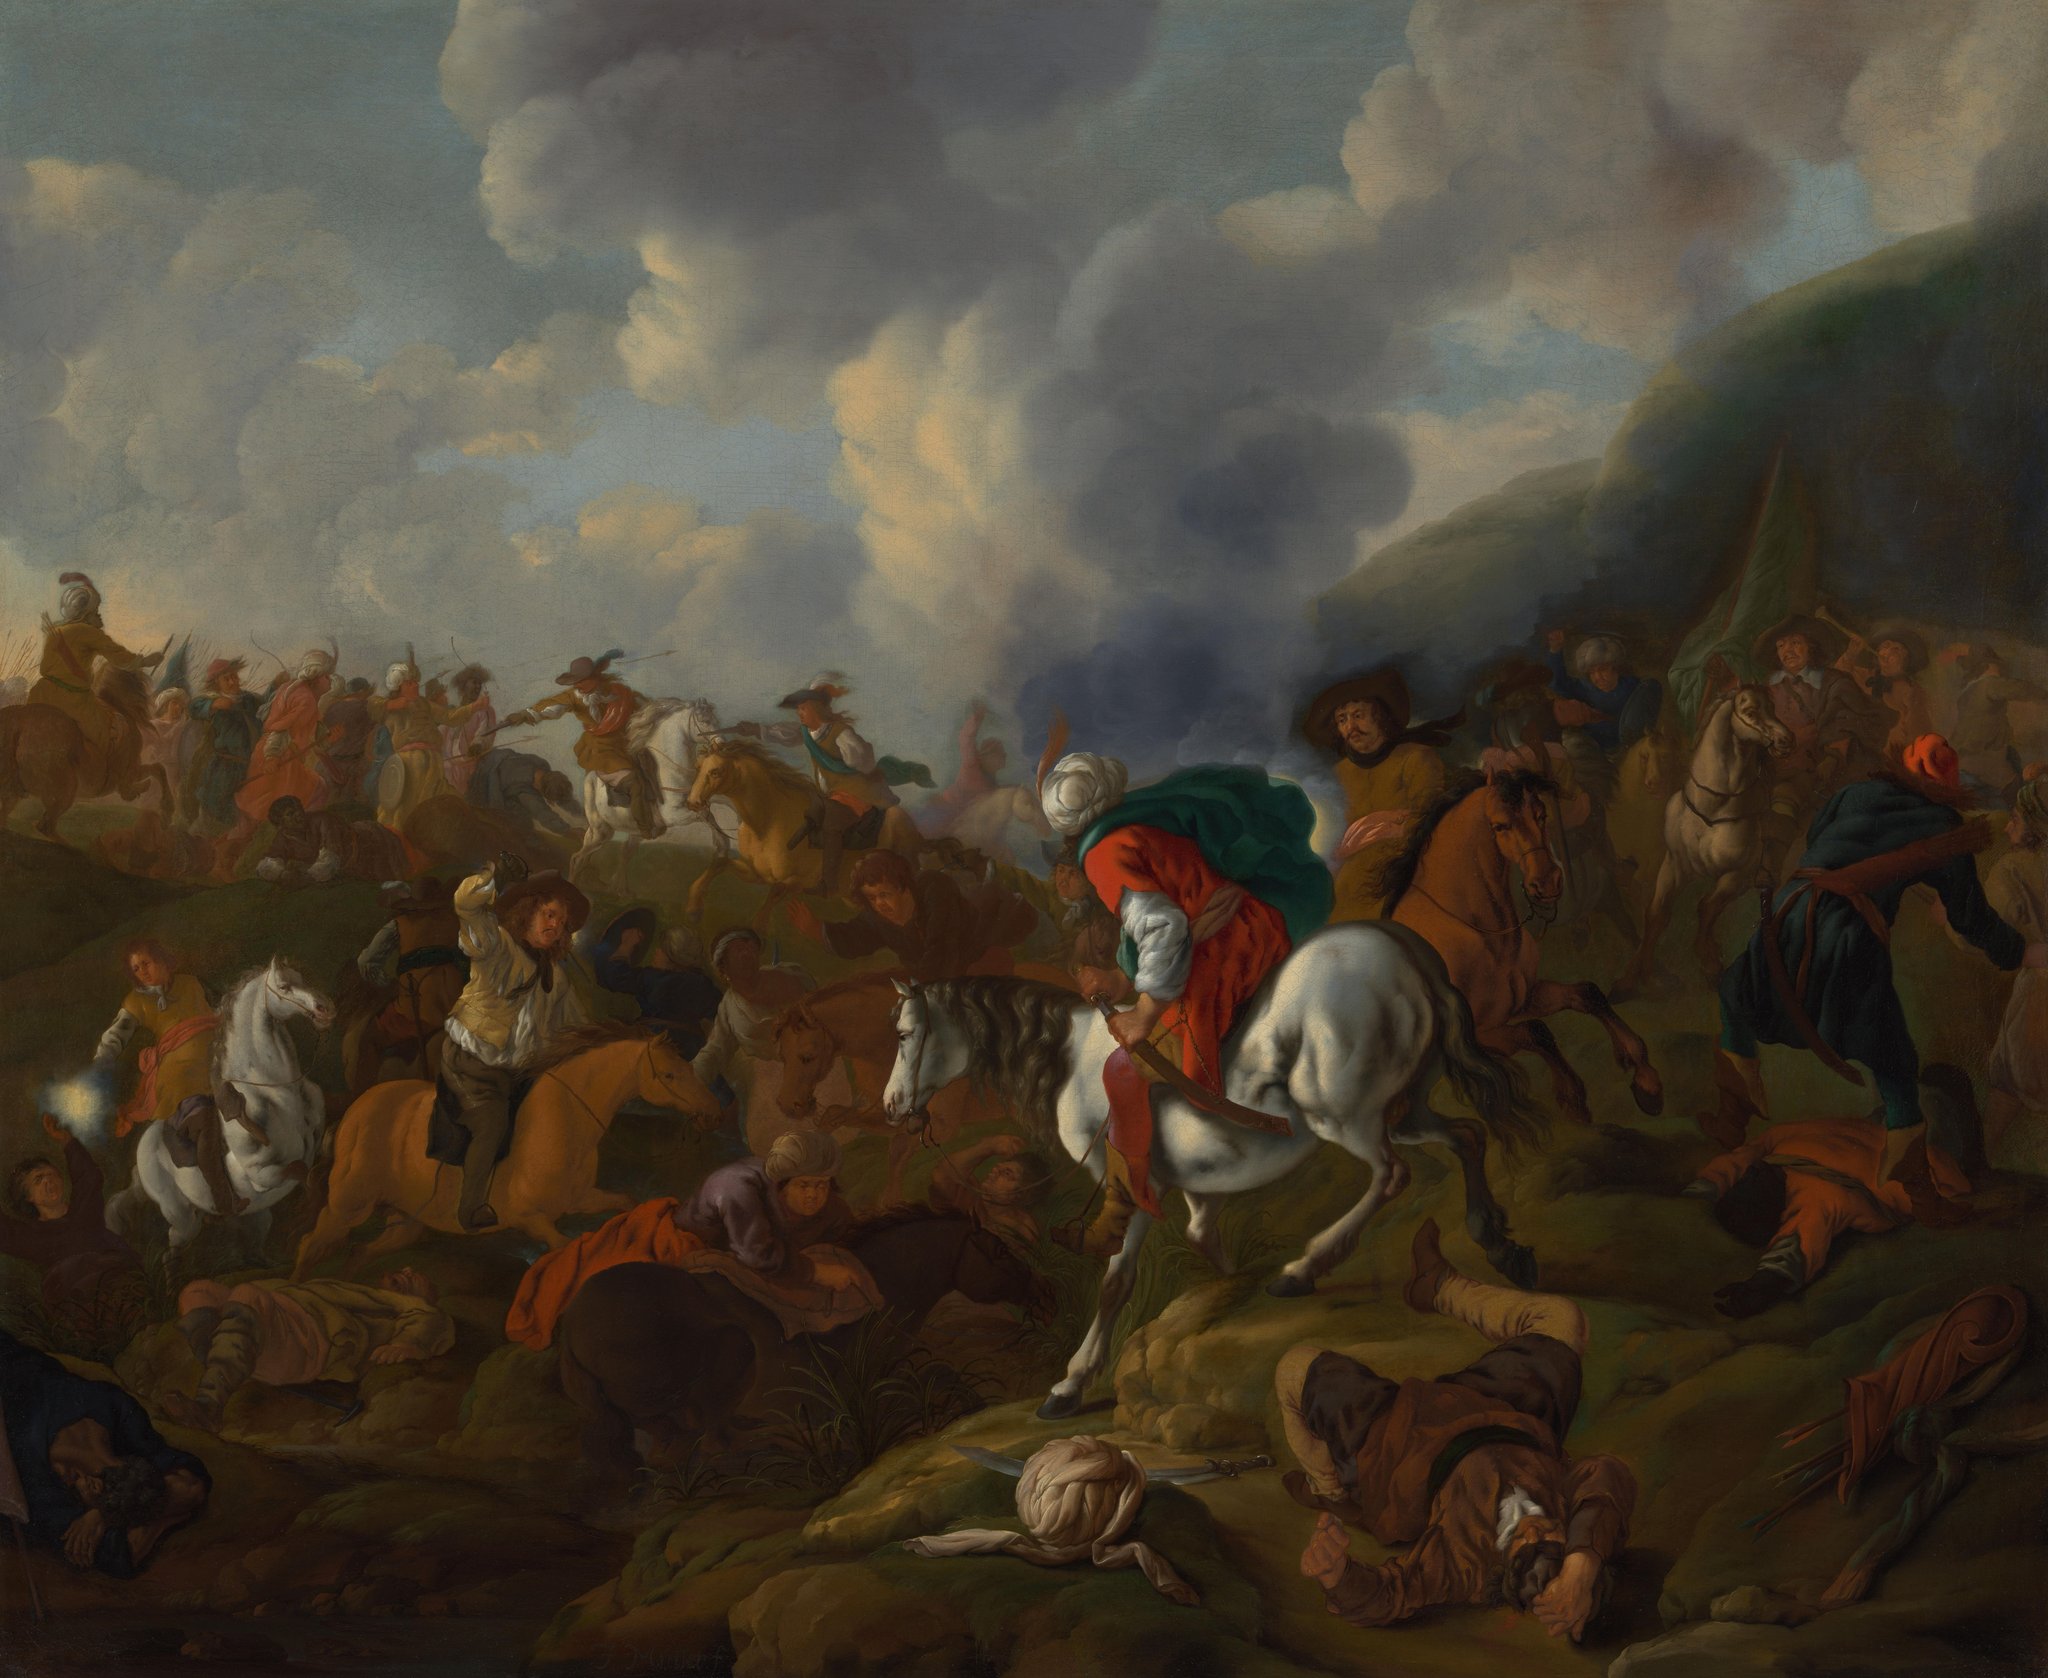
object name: painting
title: A Cavalry Encounter between Turkish Troops and the Troops of the Austrian Emperor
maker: jacques muller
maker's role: painter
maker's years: 1608-1673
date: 1645-1673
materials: canvas, oil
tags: battle (+ cavalry, horsemen)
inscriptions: signature: ‘J. Muller f.’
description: Ruitergevecht tussen Turkse troepen en troepen van de Oostenrijkse keizer. In het midden een handgevecht tussen een Turkse en een Oostenrijkse ruiter. Op de voorgrond een gewonde Turkse soldaat. Op de achtergrond stijgen rookwolken op boven het slagveld.